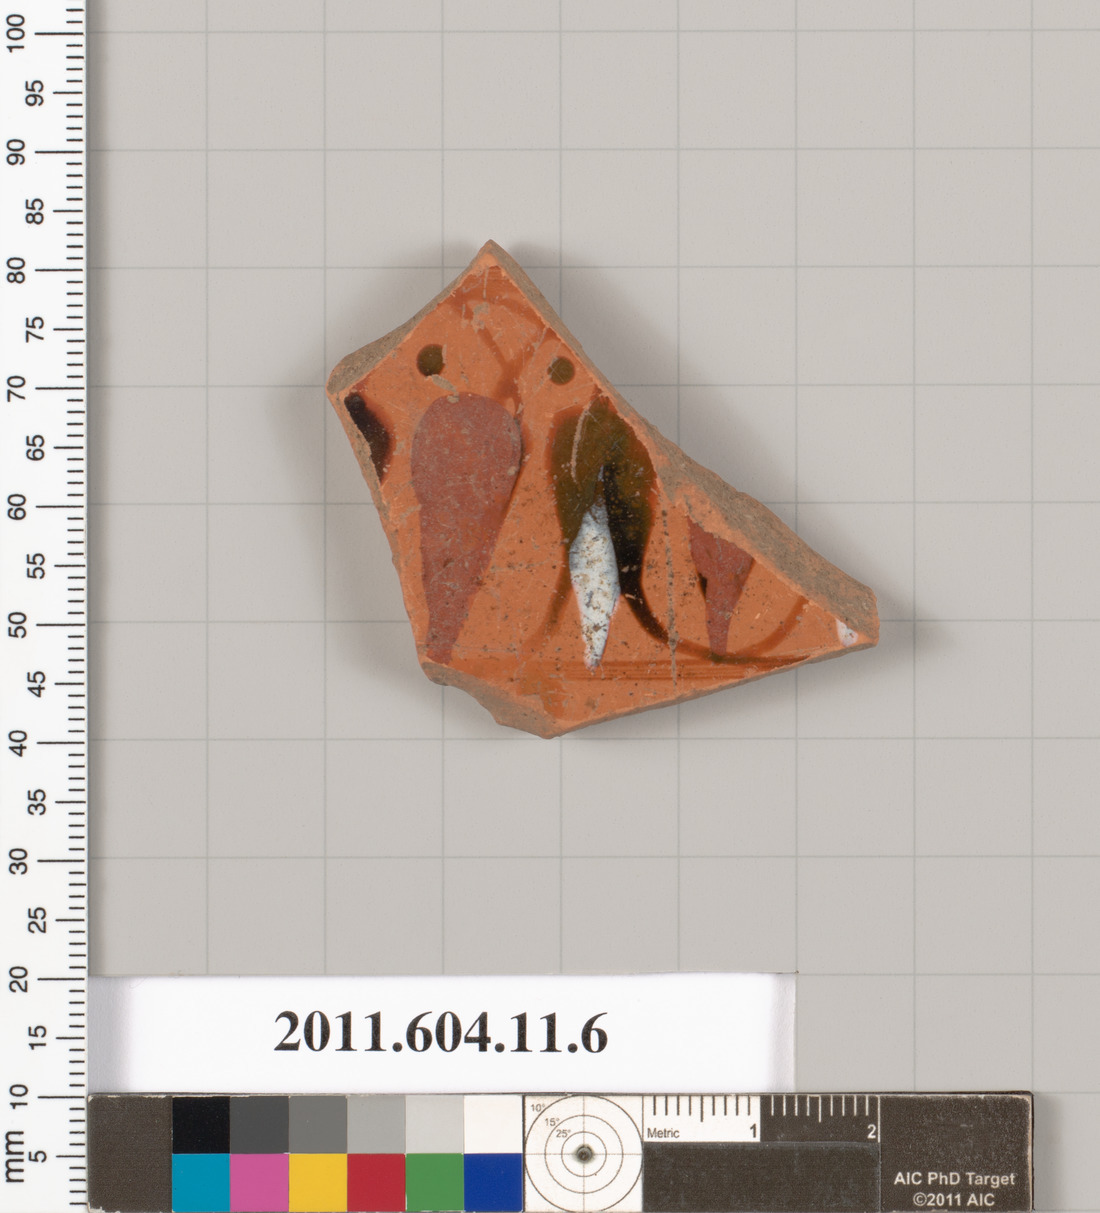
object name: neck amphora fragment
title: Terracotta fragment of a neck-amphora (jar)?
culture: greek, chalcidian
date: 530-510 BCE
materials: terracotta